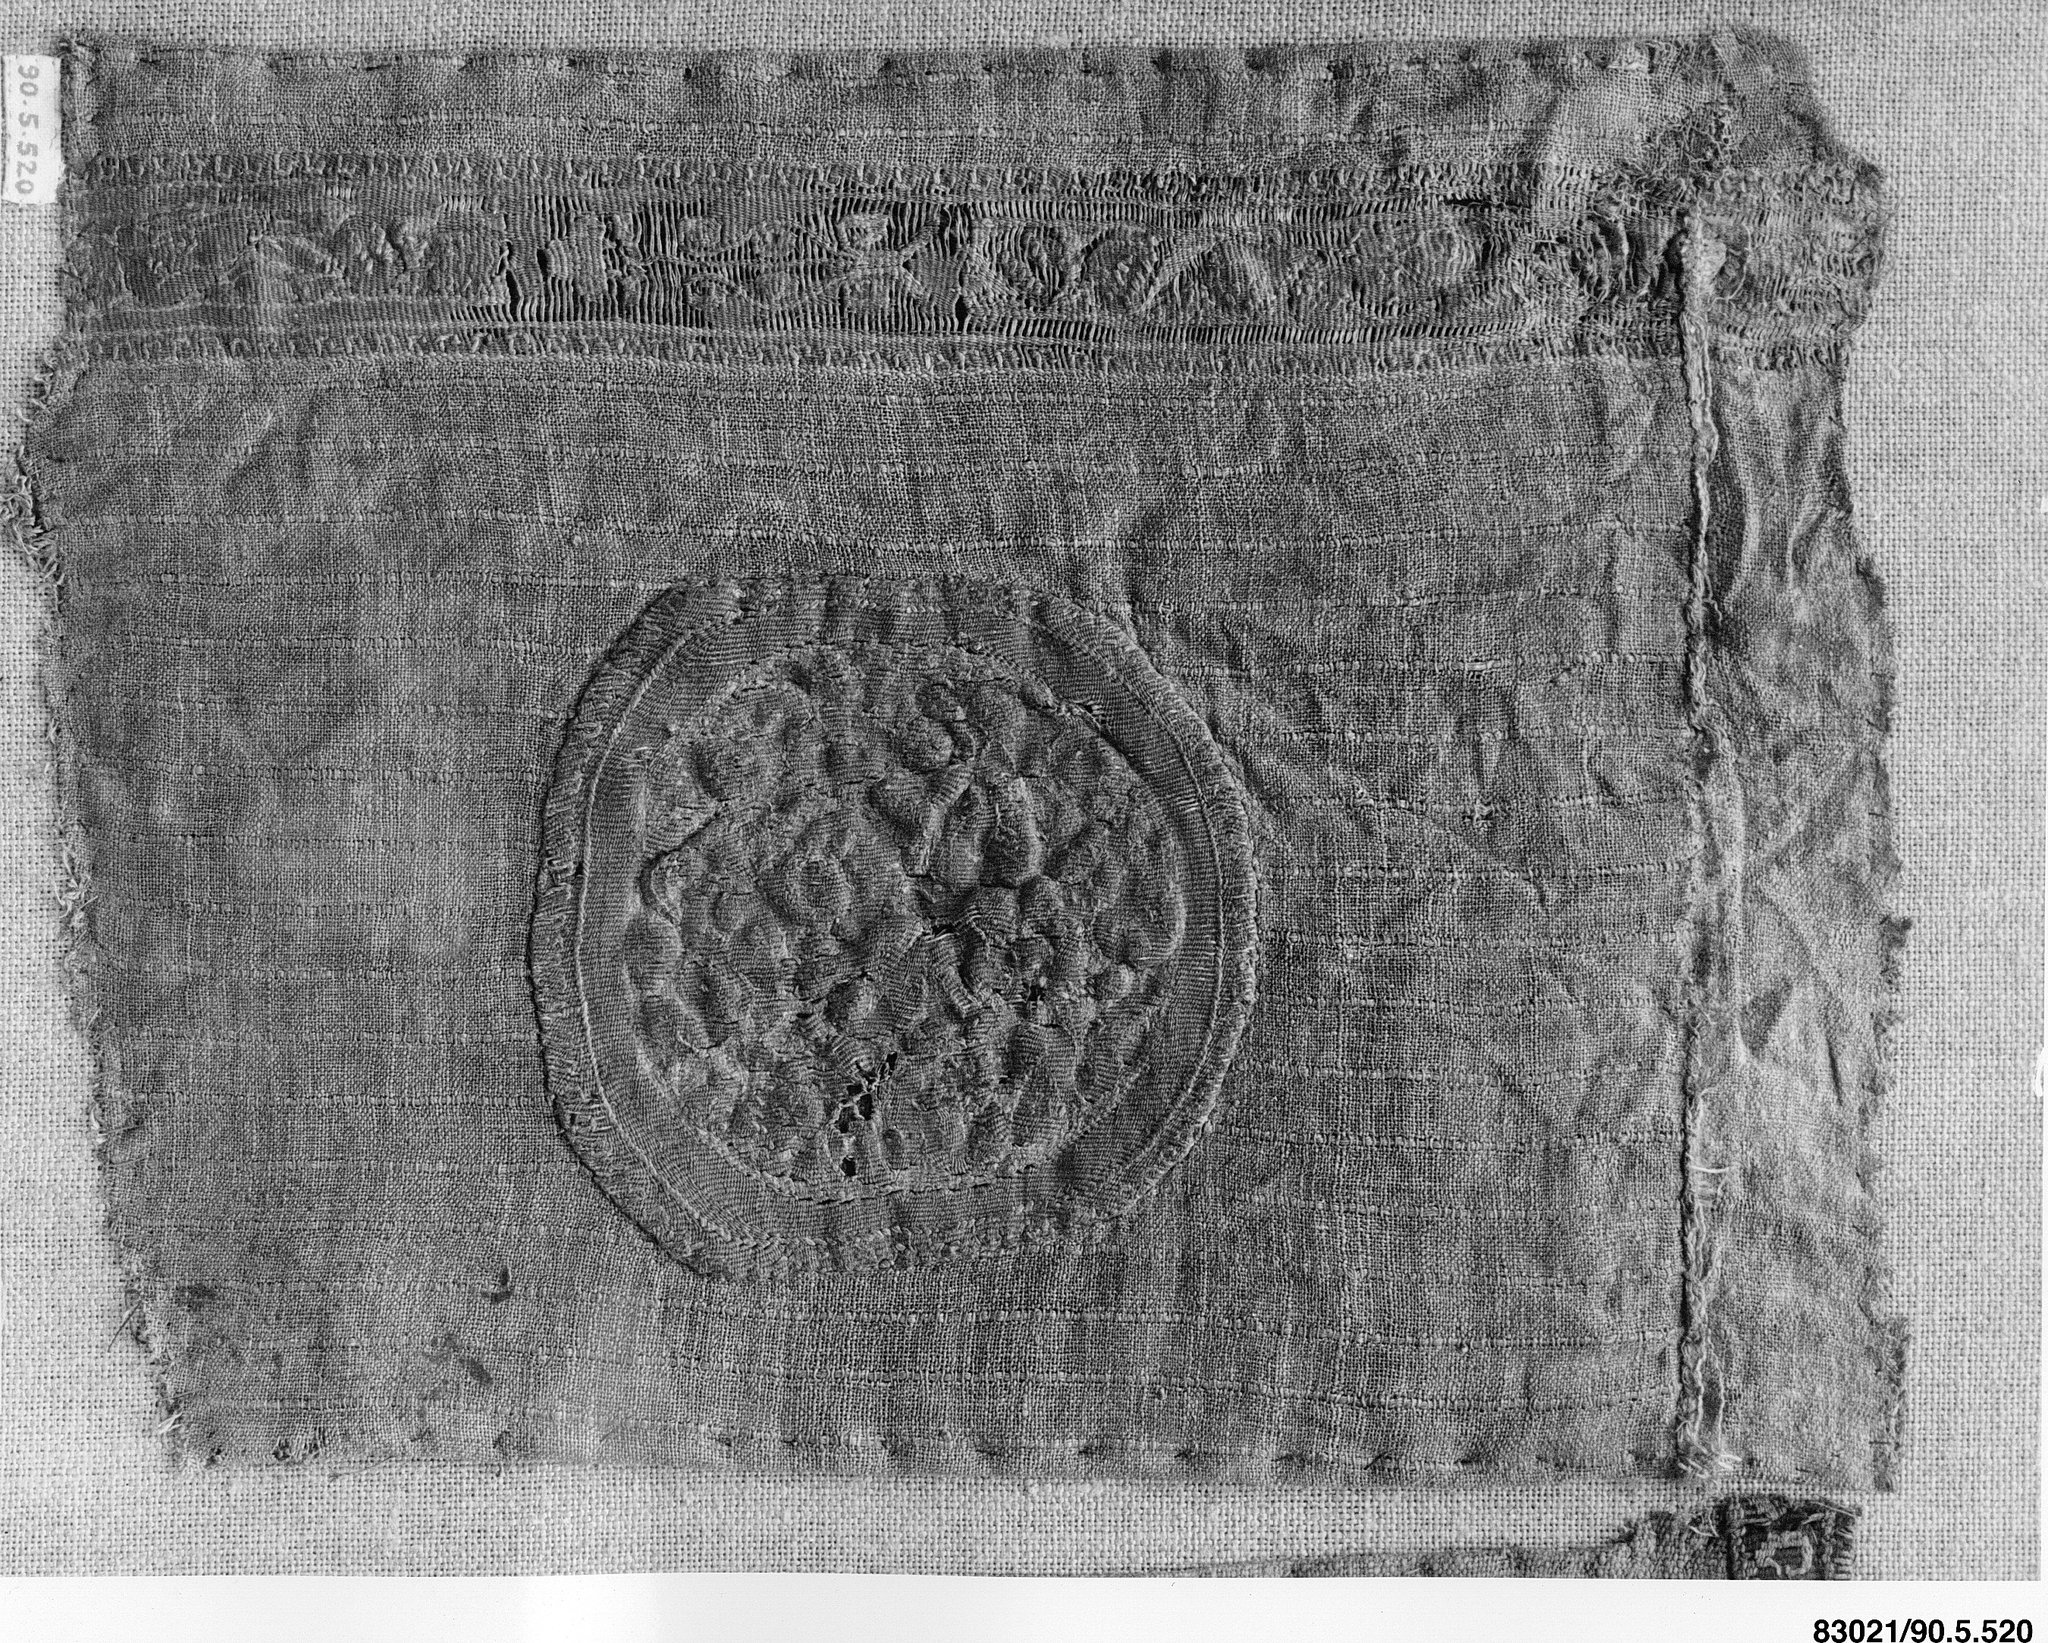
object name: textile fragment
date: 301-400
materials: linen, wool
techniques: weave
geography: egypt